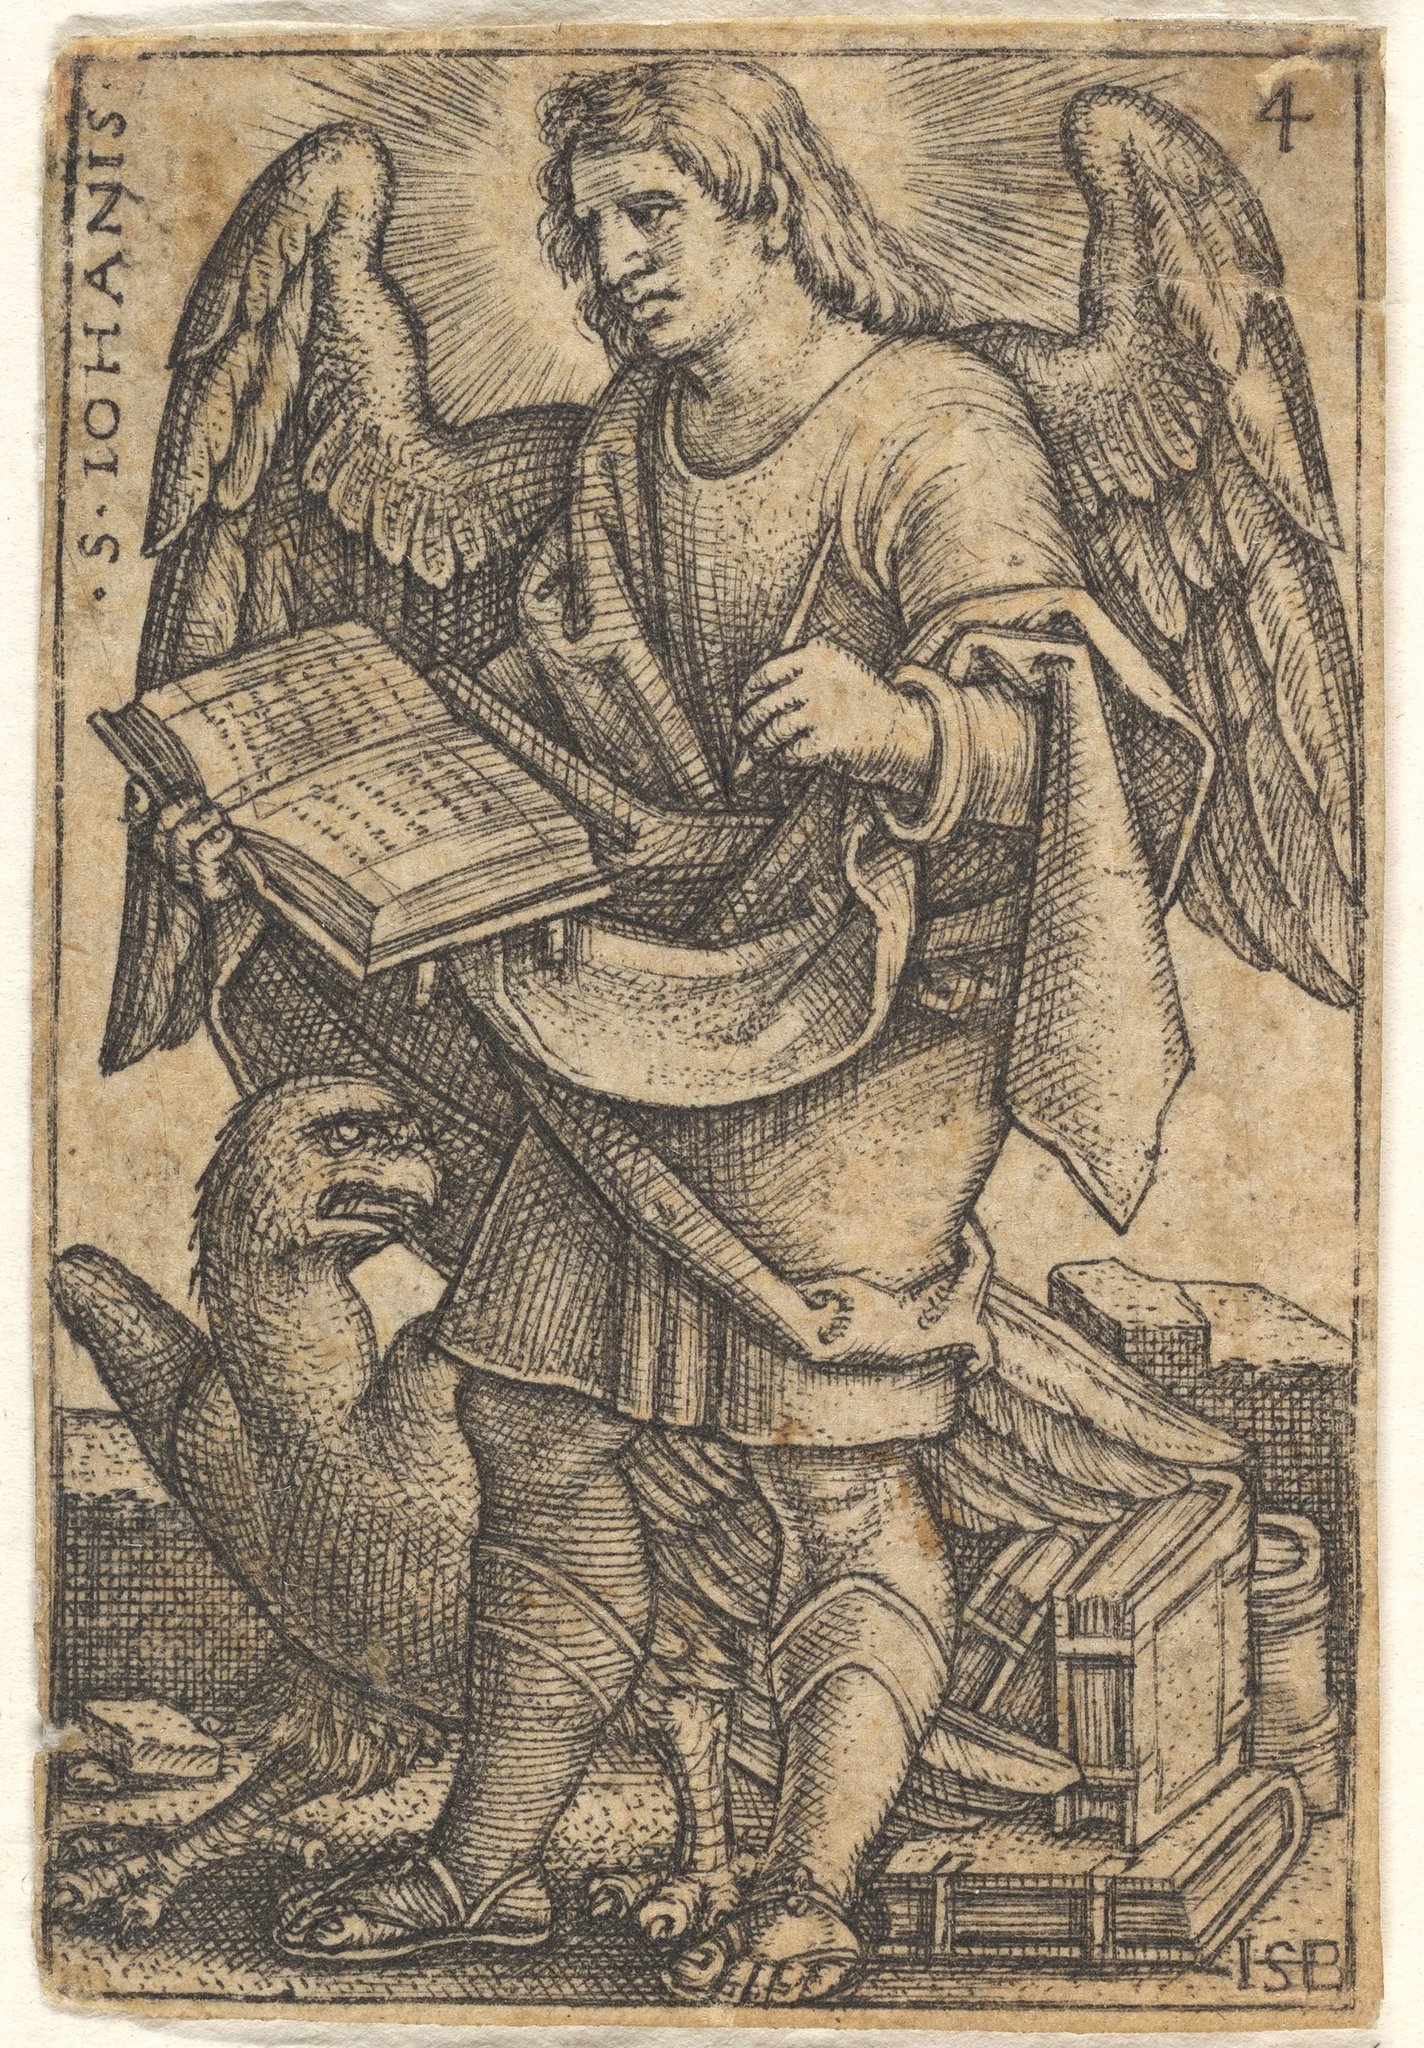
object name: print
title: Saint John with his head turned three-quarters to the left, with a book in his right hand and an eagle at his fee, plate 4 from "The Four Evangelists"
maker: sebald beham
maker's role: artist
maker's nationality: german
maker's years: 1500-1550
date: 1541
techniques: engraving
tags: eagles,books,saint john the evangelist